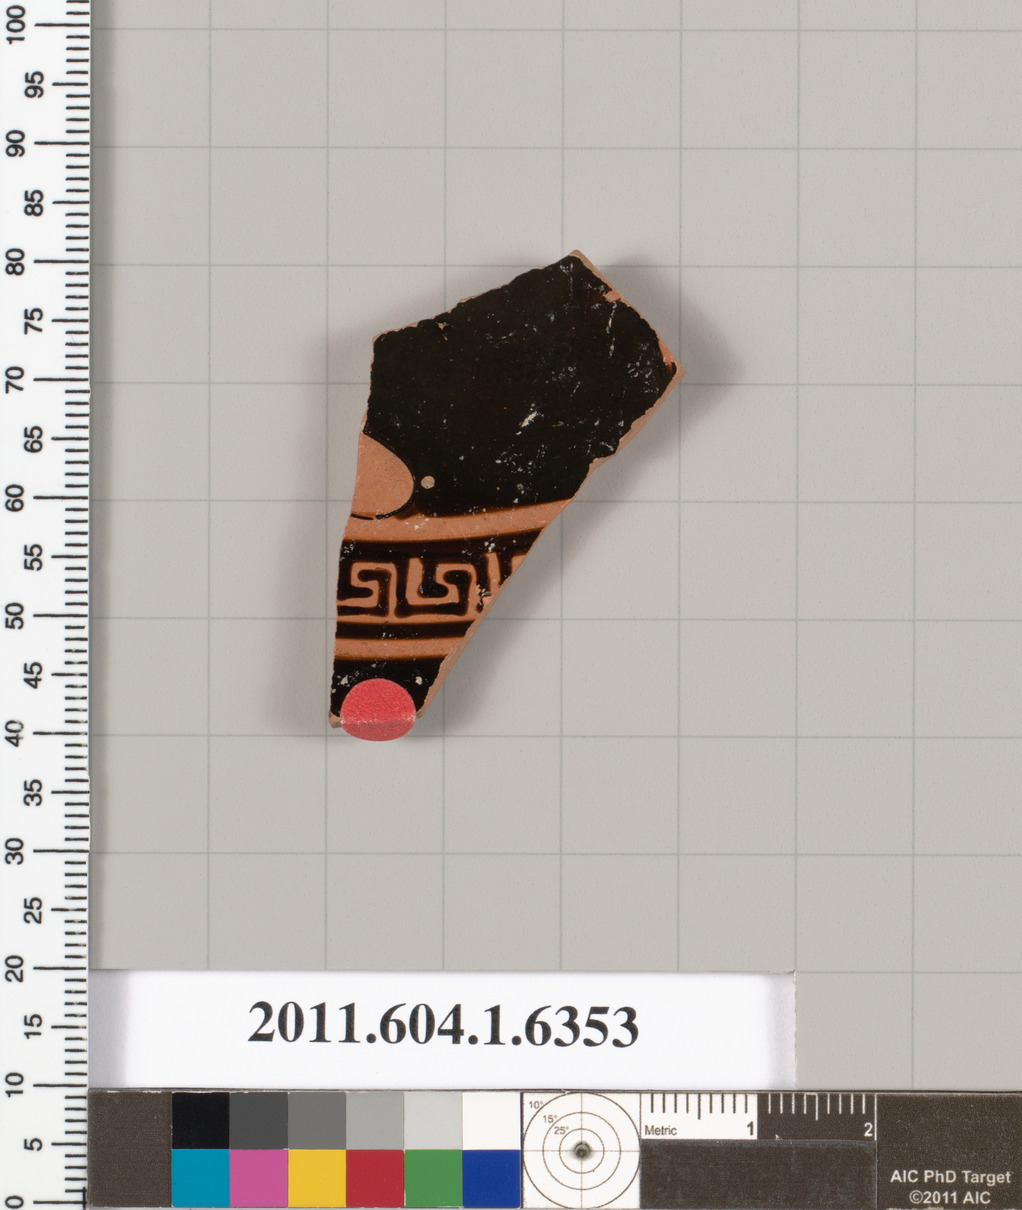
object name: kylix fragment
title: Terracotta fragment of a kylix (drinking cup)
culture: greek, attic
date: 500-480 BCE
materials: terracotta